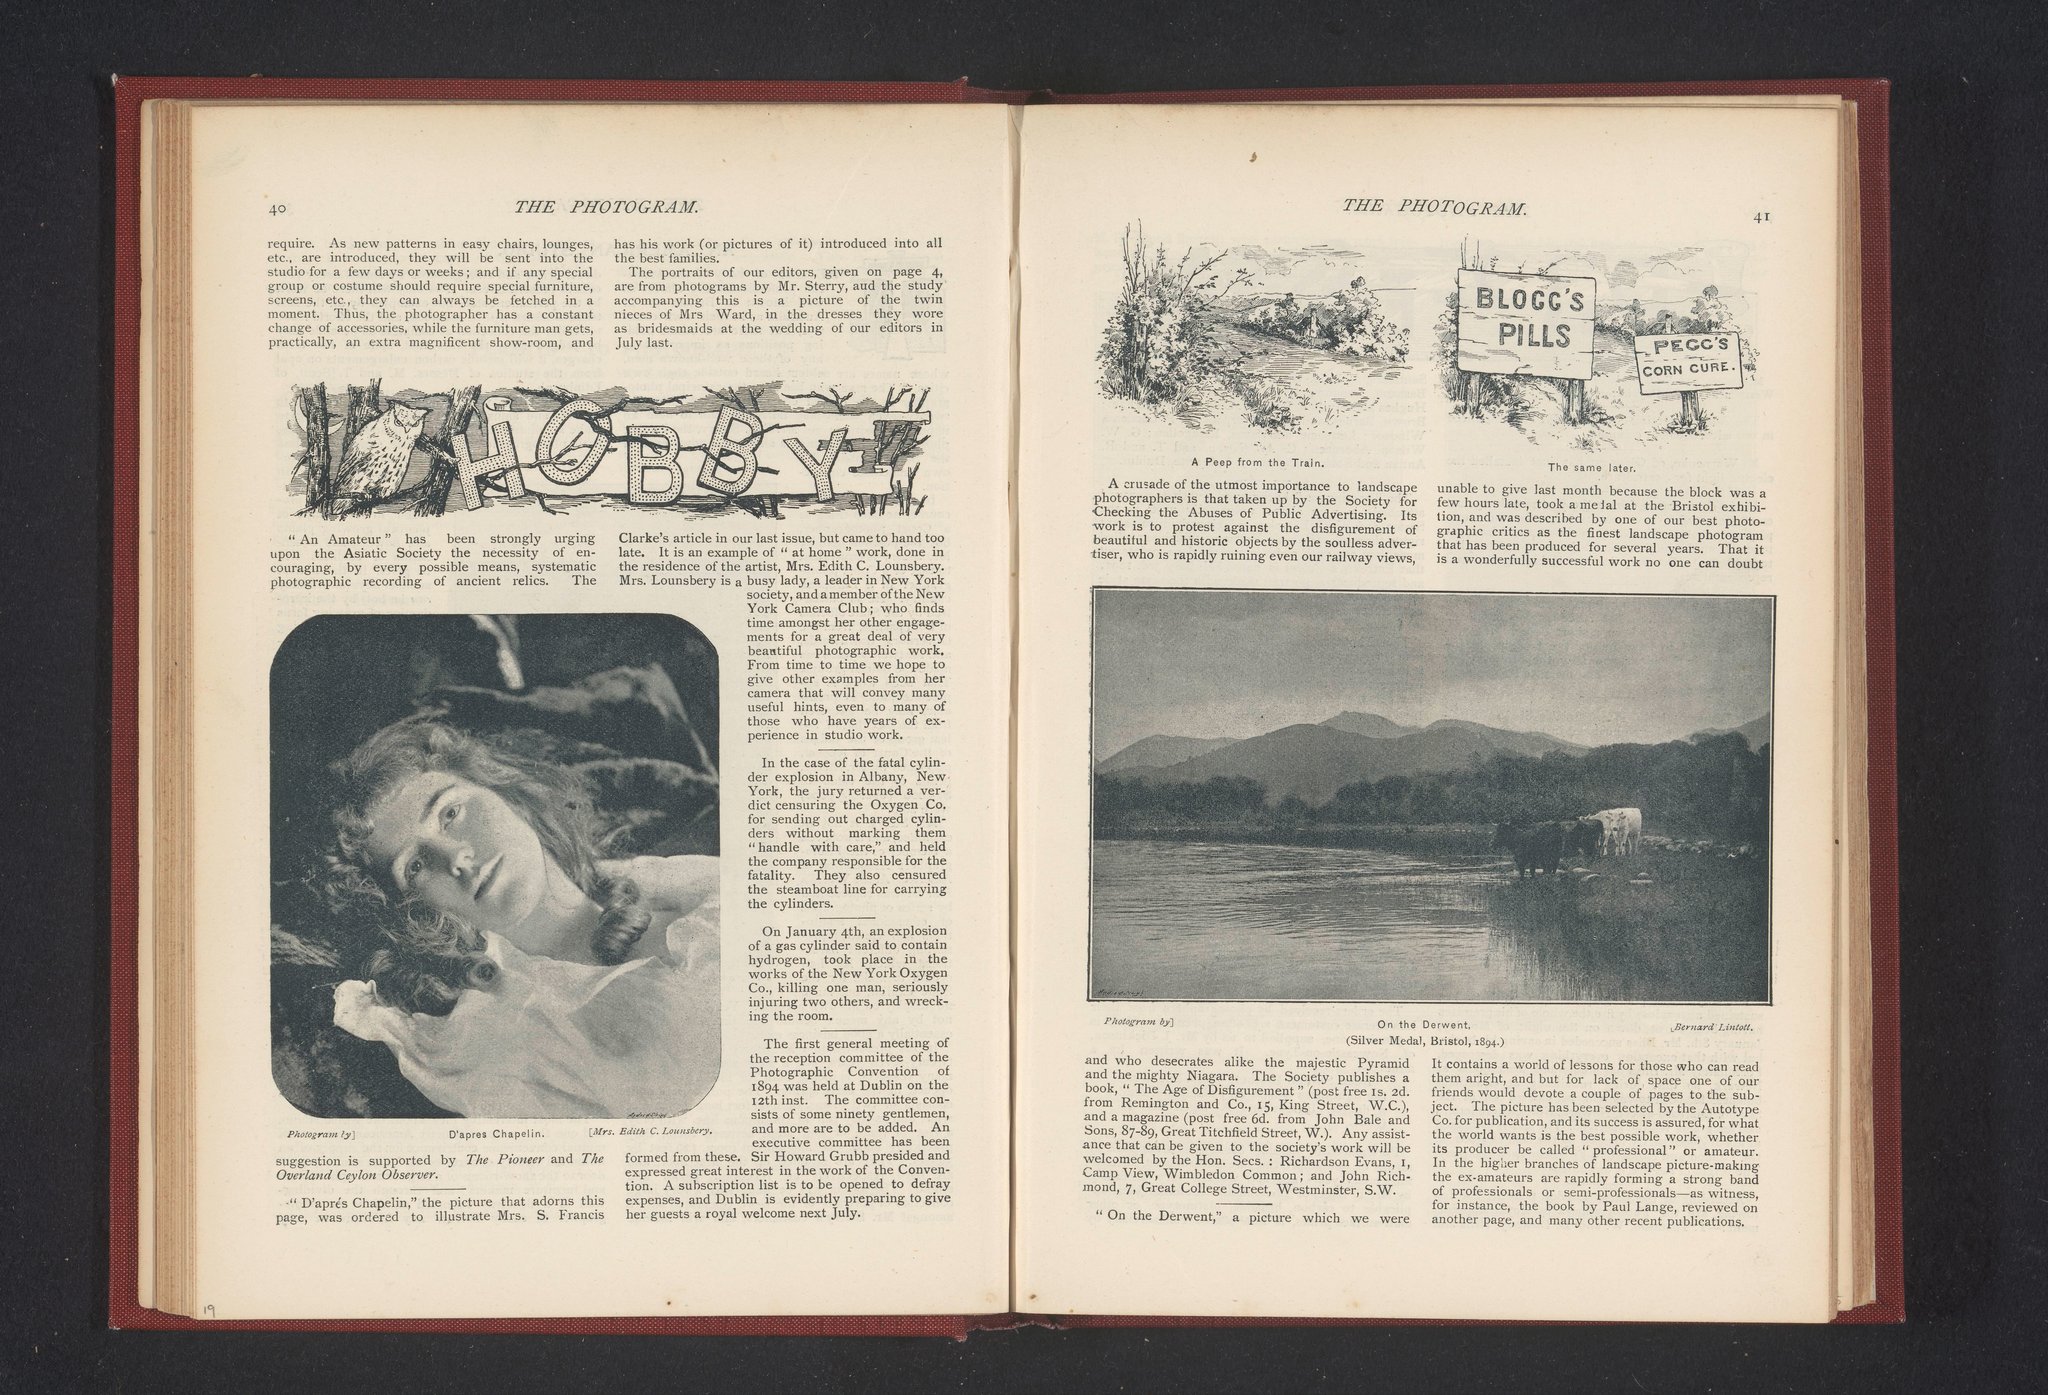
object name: page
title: On the Derwent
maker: bernard lintott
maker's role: fotograaf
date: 1889-1894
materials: paper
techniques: autotype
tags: landscapes, river